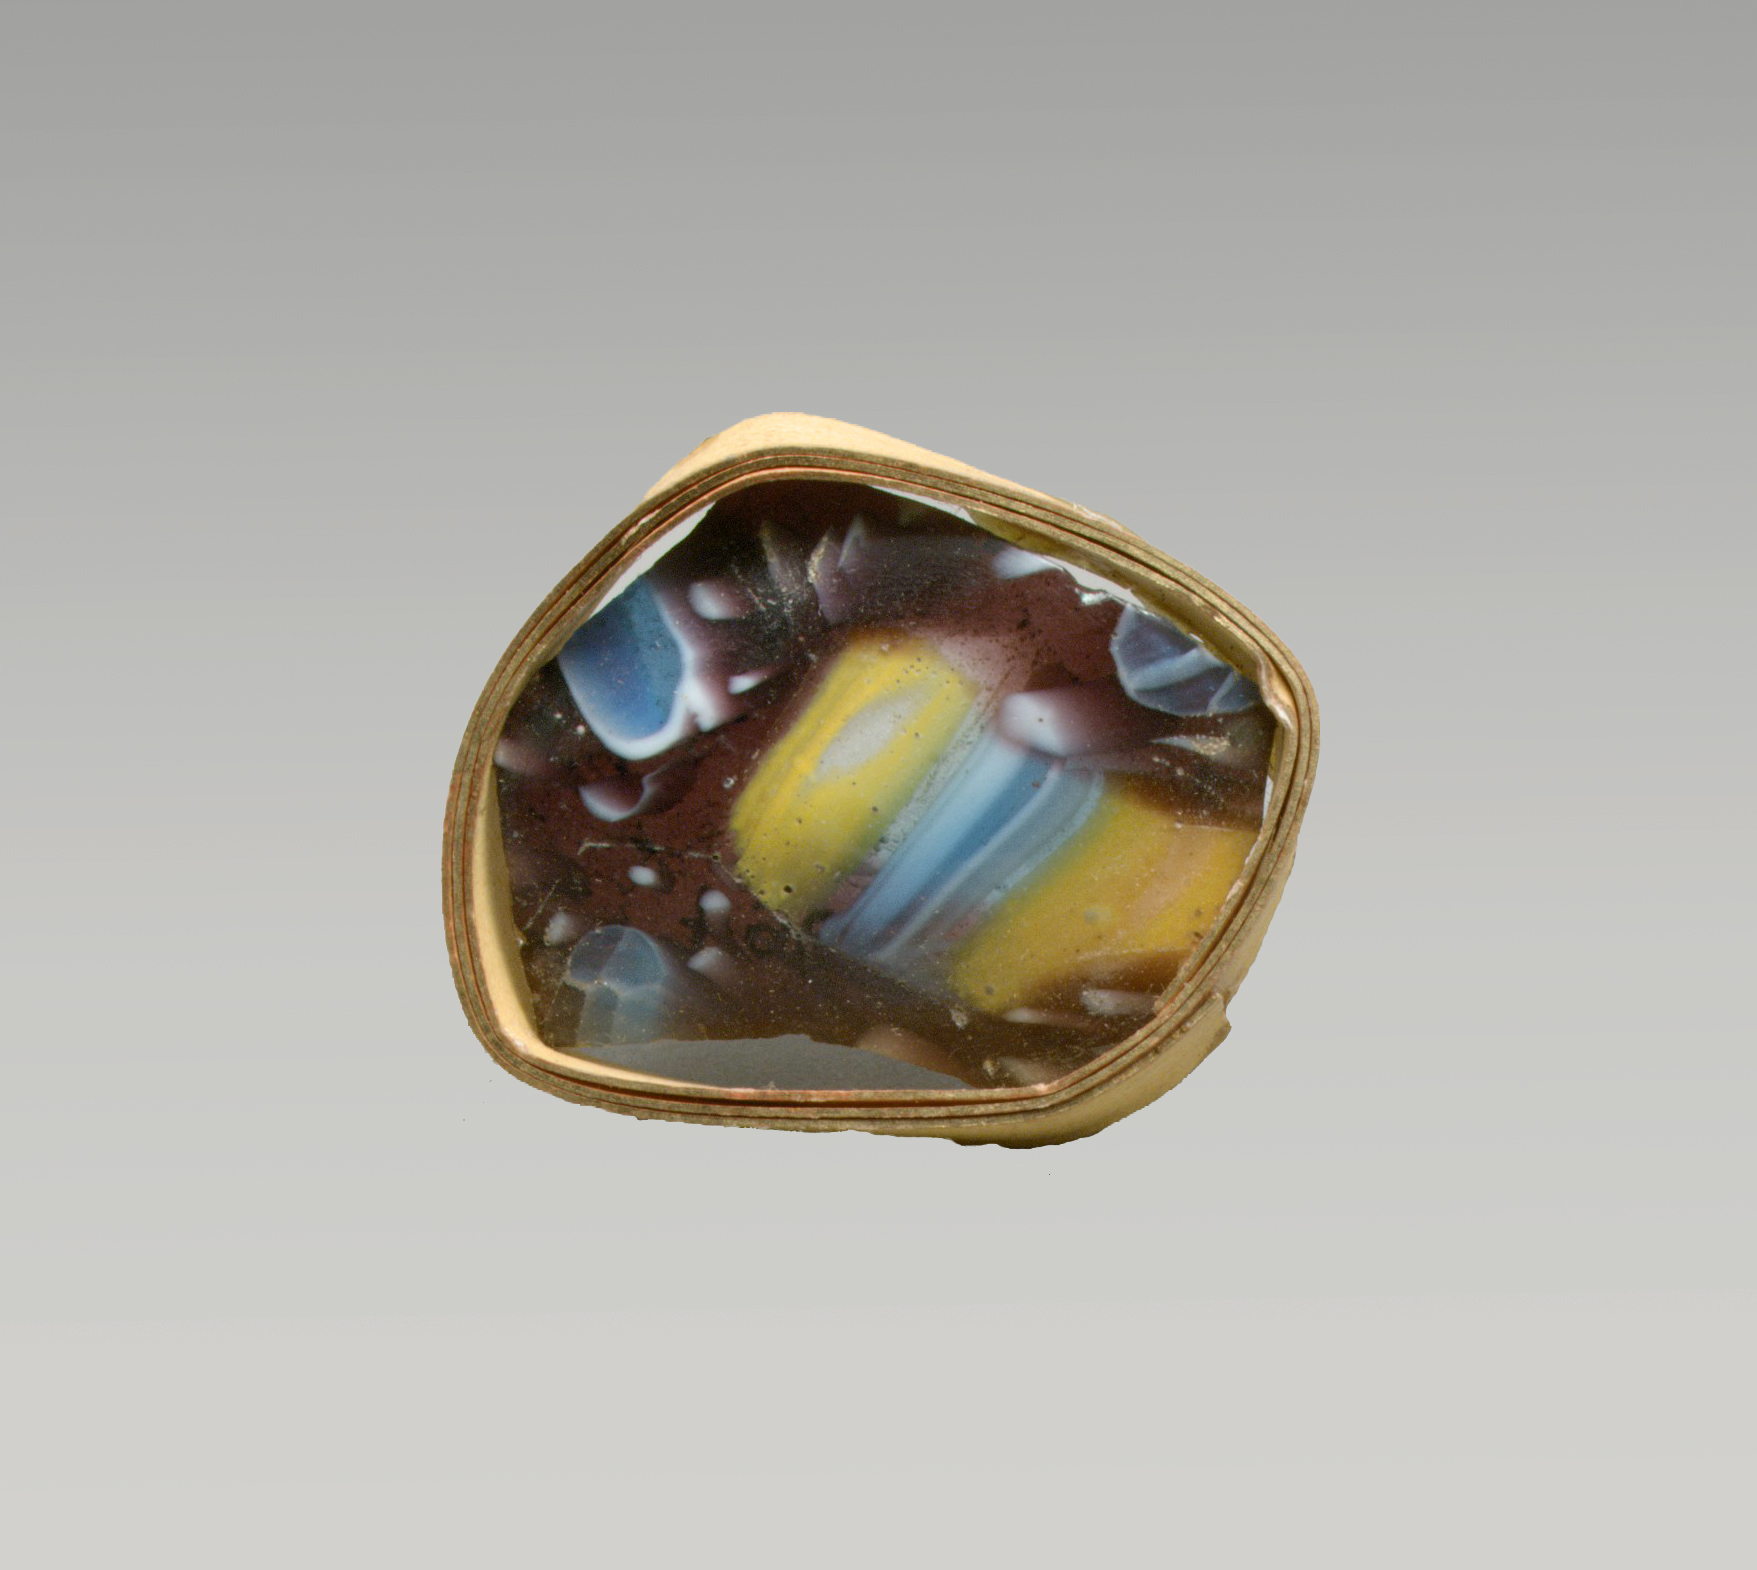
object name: fragment, mosaic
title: Glass mosaic fragment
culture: roman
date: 34 BCE-33 CE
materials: glass